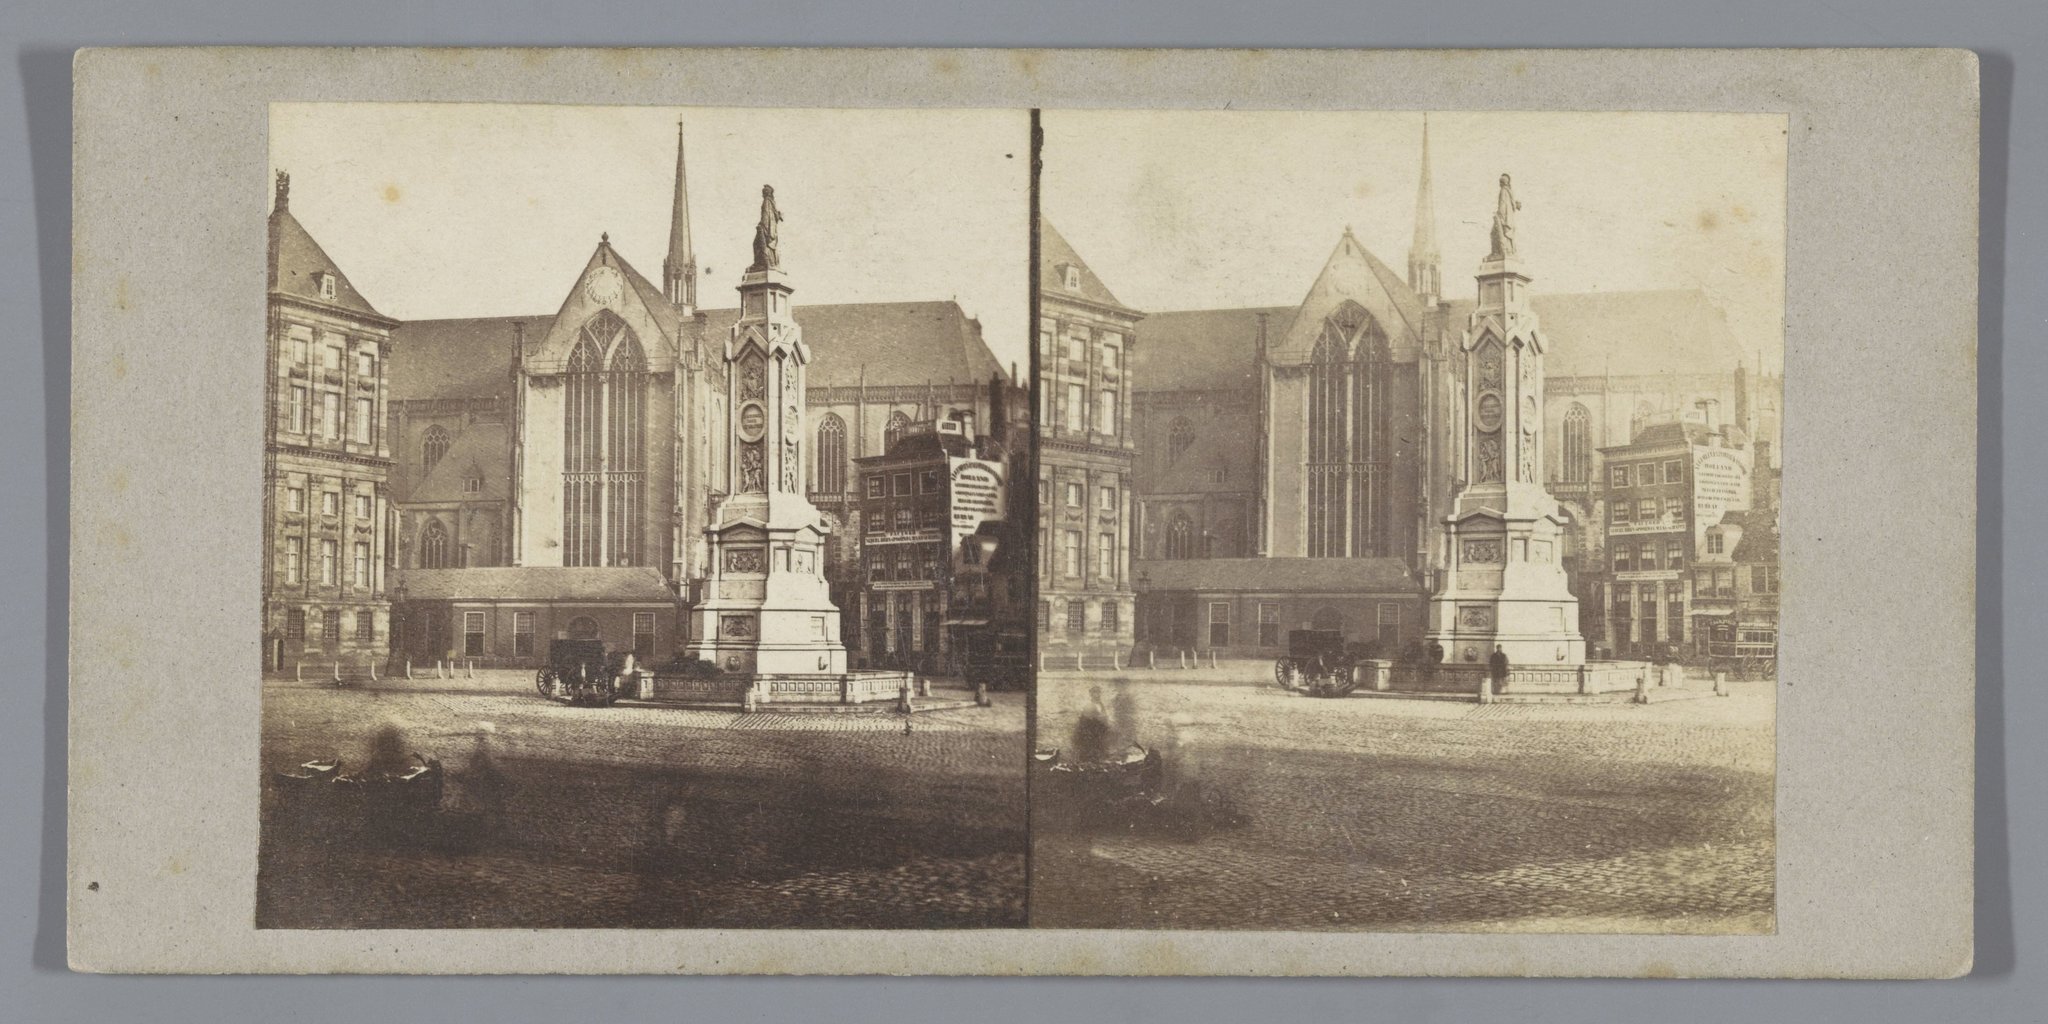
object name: stereograph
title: Monument De Eendracht, ofwel 'Naatje op de Dam', Amsterdam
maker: Anonymous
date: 1856-1858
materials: cardboard, paper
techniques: albumen print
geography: amsterdam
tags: square, place, circus, etc., monument, statue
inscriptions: inscription: ‘Monument op den Dam/ No 55 Amsterdam/ GB no. 38’